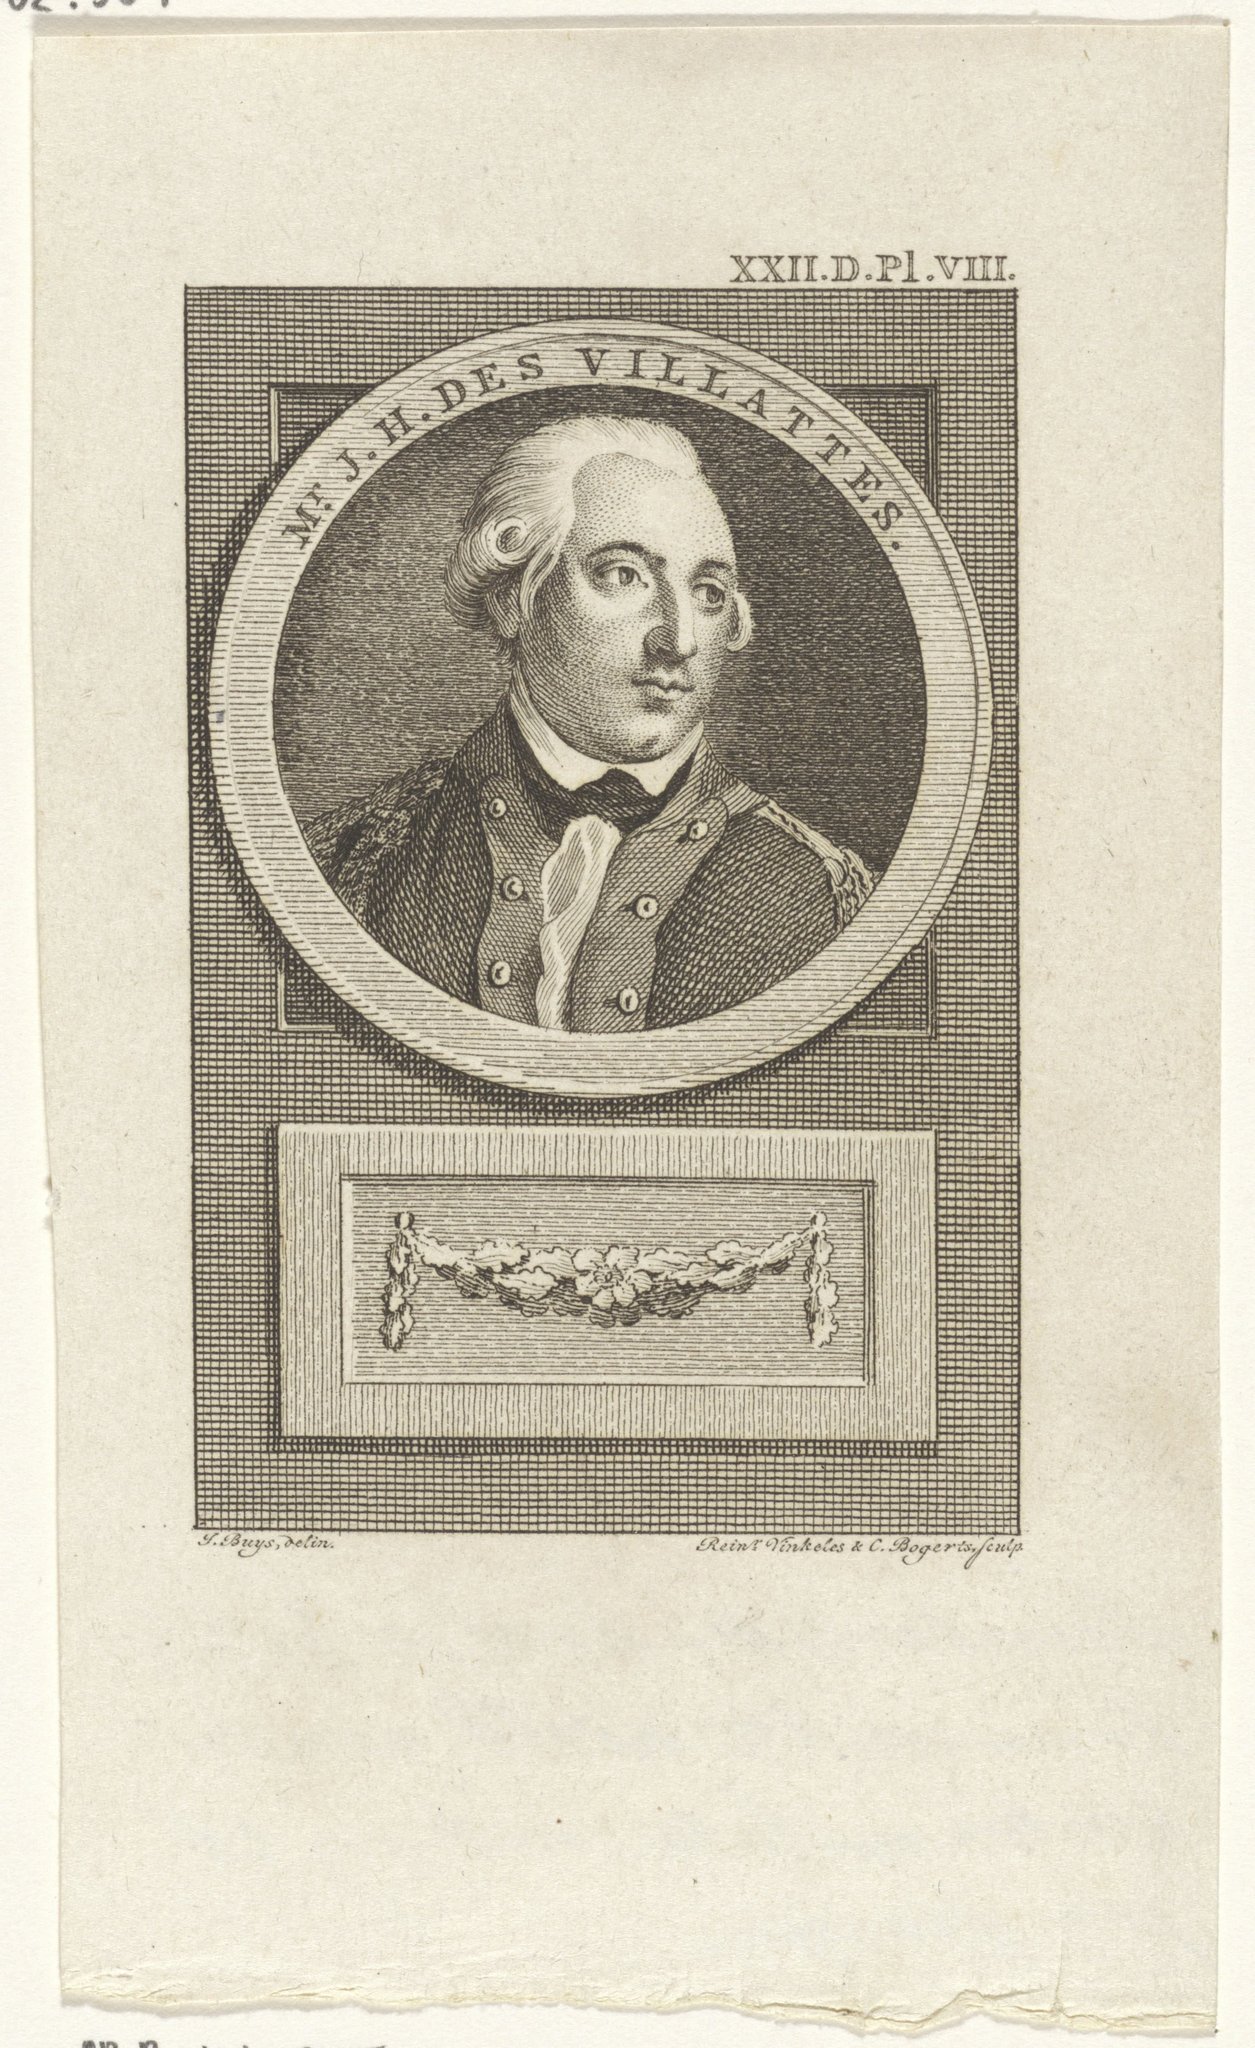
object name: print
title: Portret van Jean Henri des Villattes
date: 1783-1795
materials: paper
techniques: engraving, etching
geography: amsterdam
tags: the hague, publisher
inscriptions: collector's mark: Lugt 2228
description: Prent gebruikt in: Fokke, Jan. Geschiedenissen der Vereenigde Nederlanden voor de vaderlandsche jeugd Ie-XXVste deel. Amsterdam: Johannes Allart, 1783-1795. Deel XXII.